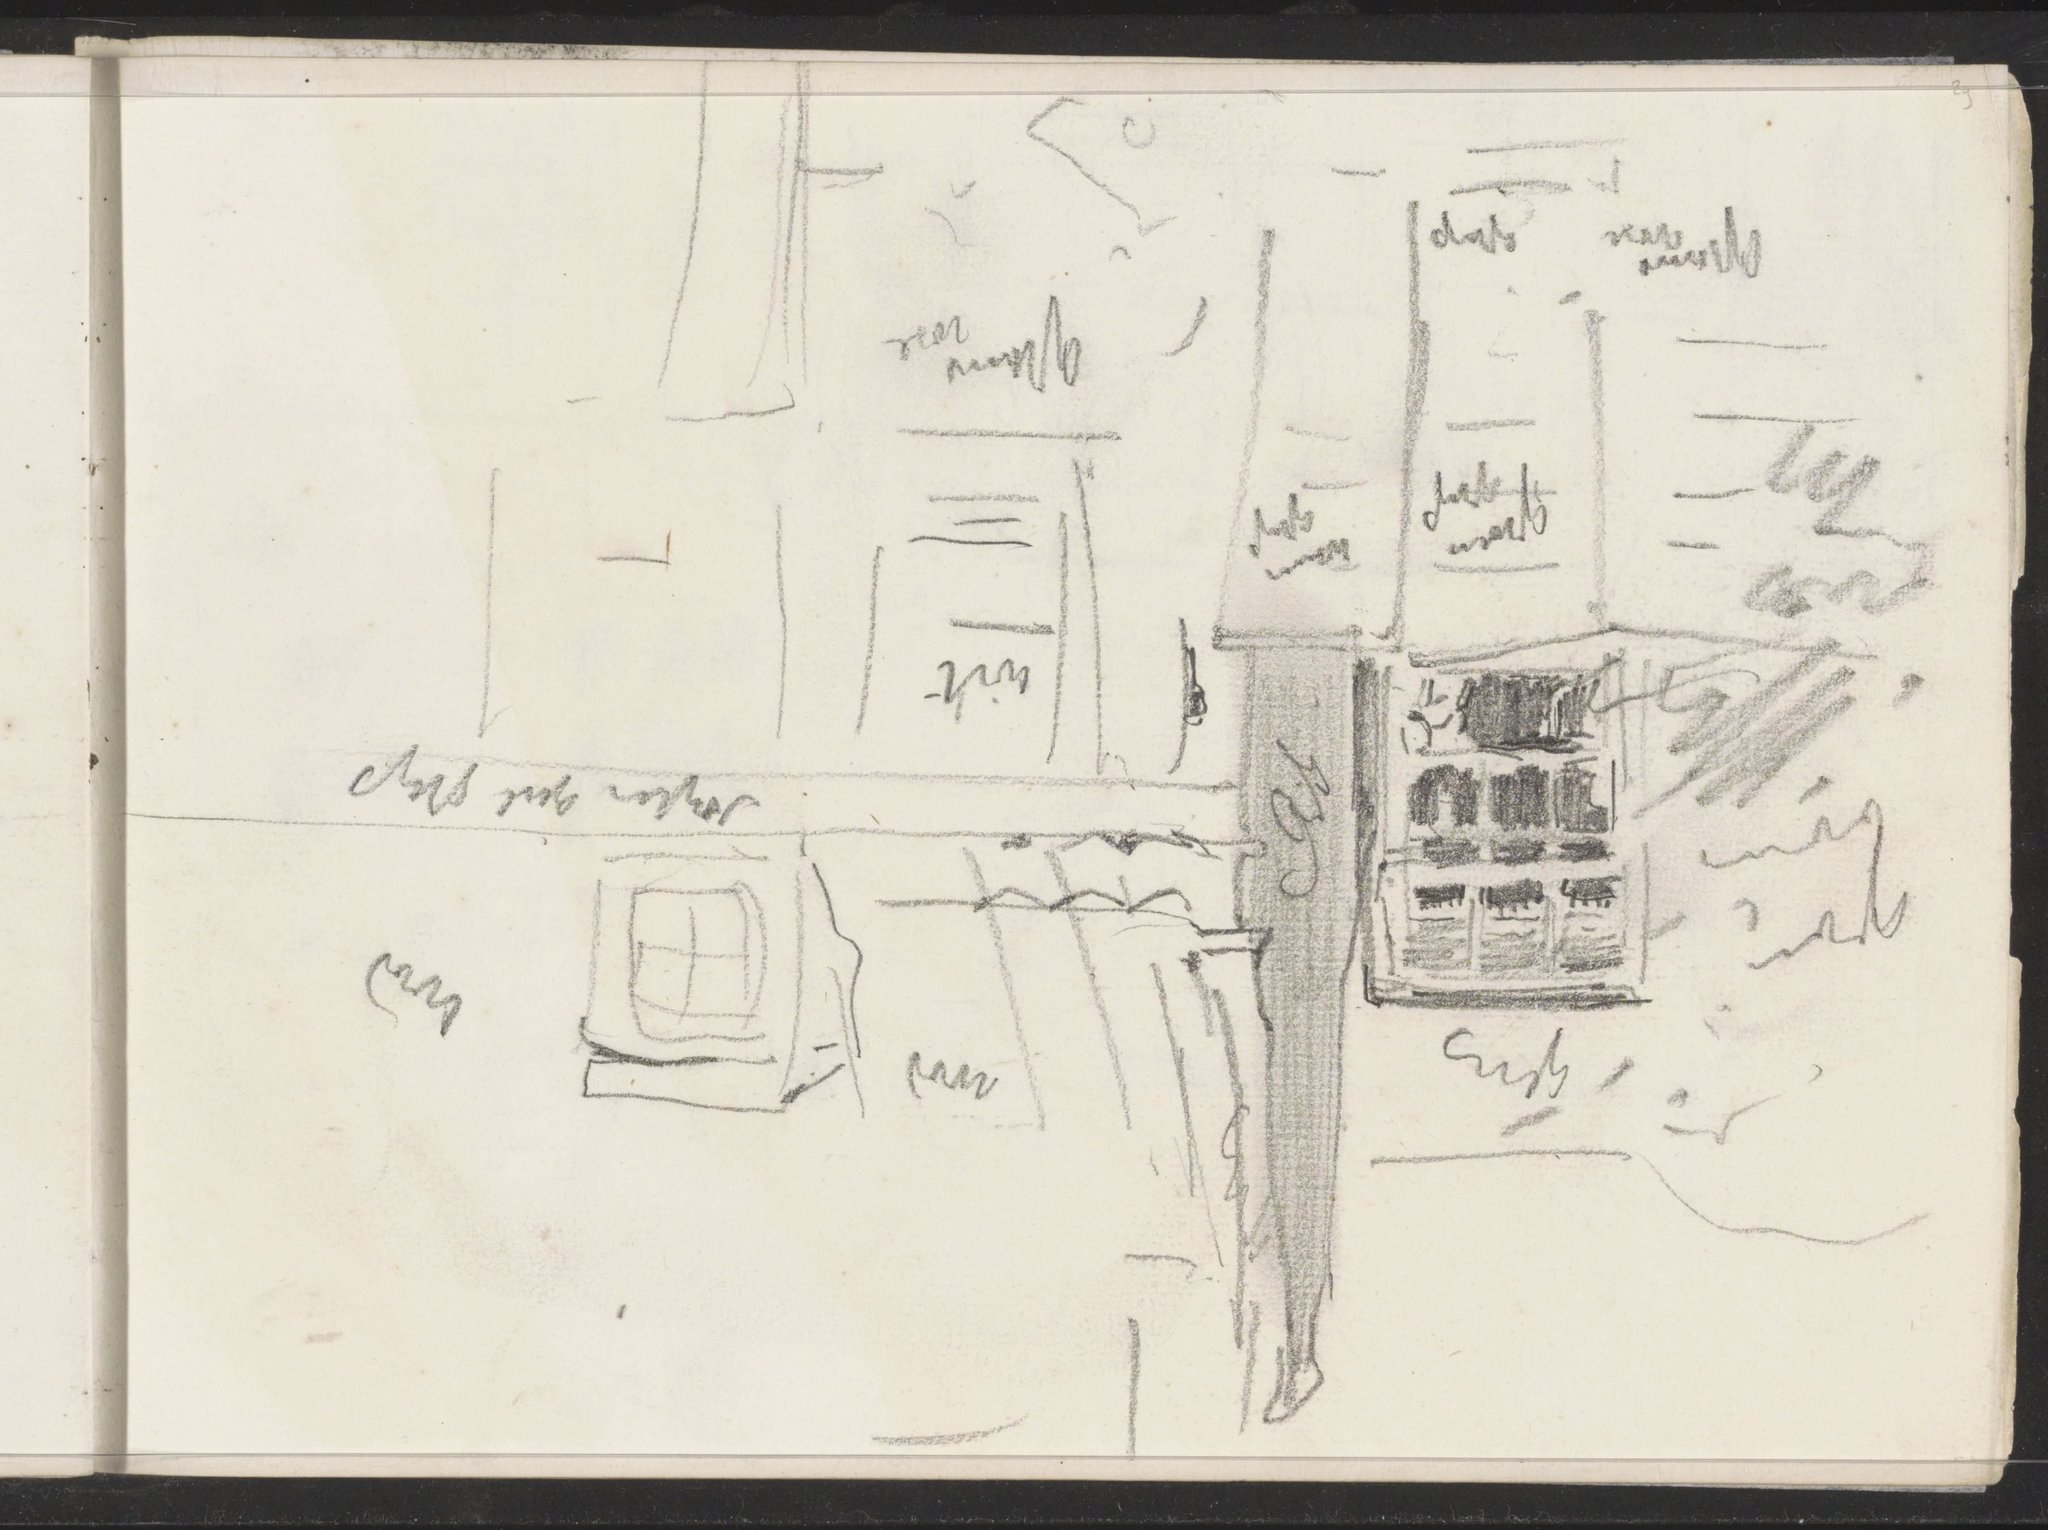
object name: sketchbook leaf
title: Huizen aan de Voorstraatshaven te Dordrecht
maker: willem witsen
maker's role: draughtsman, painter, print maker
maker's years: 1860-1923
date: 1898-1899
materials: paper, pencil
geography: dordrecht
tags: urban housing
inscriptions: kleurnotitie, handgeschreven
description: Achtergevels van Grotekerksbuurt 10 en 8, tussen de Lombardbrug en de Manhuissteiger. Pagina 29 uit een schetsboek met 17 bladen.